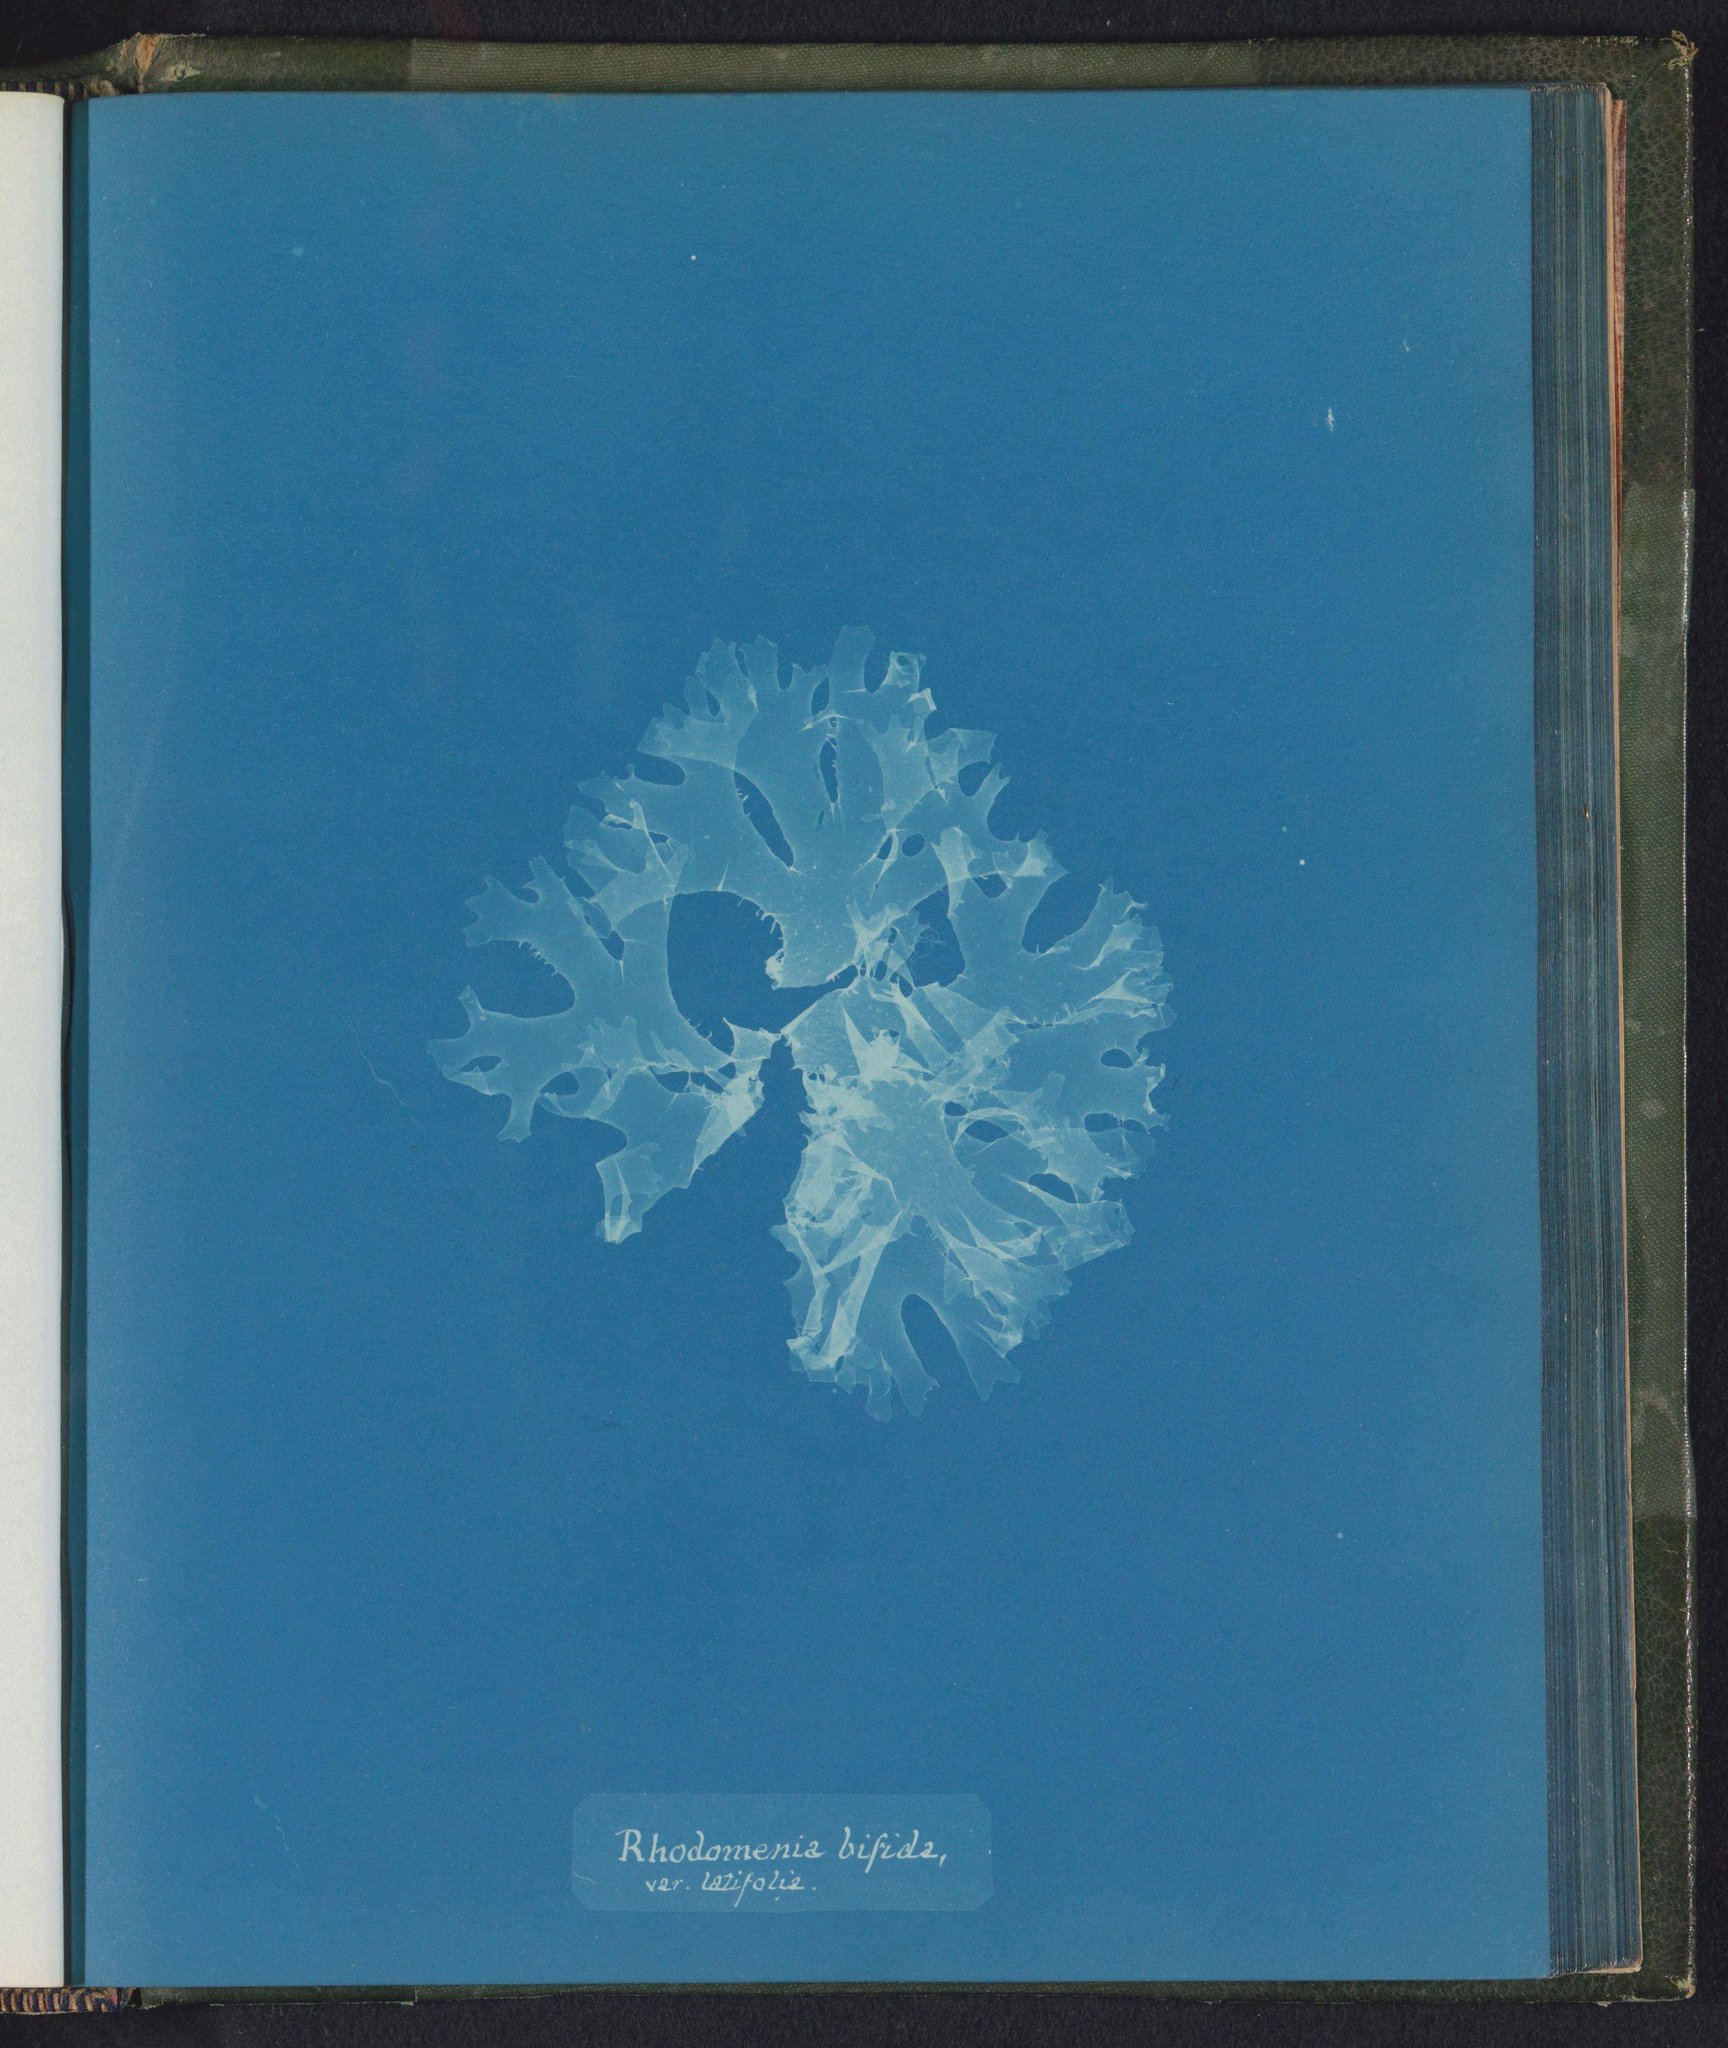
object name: photograph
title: Zeewier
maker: anna atkins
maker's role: fotograaf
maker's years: 1799-1871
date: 1843-1853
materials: photographic support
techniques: cyanotype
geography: united kingdom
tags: algae, seaweed